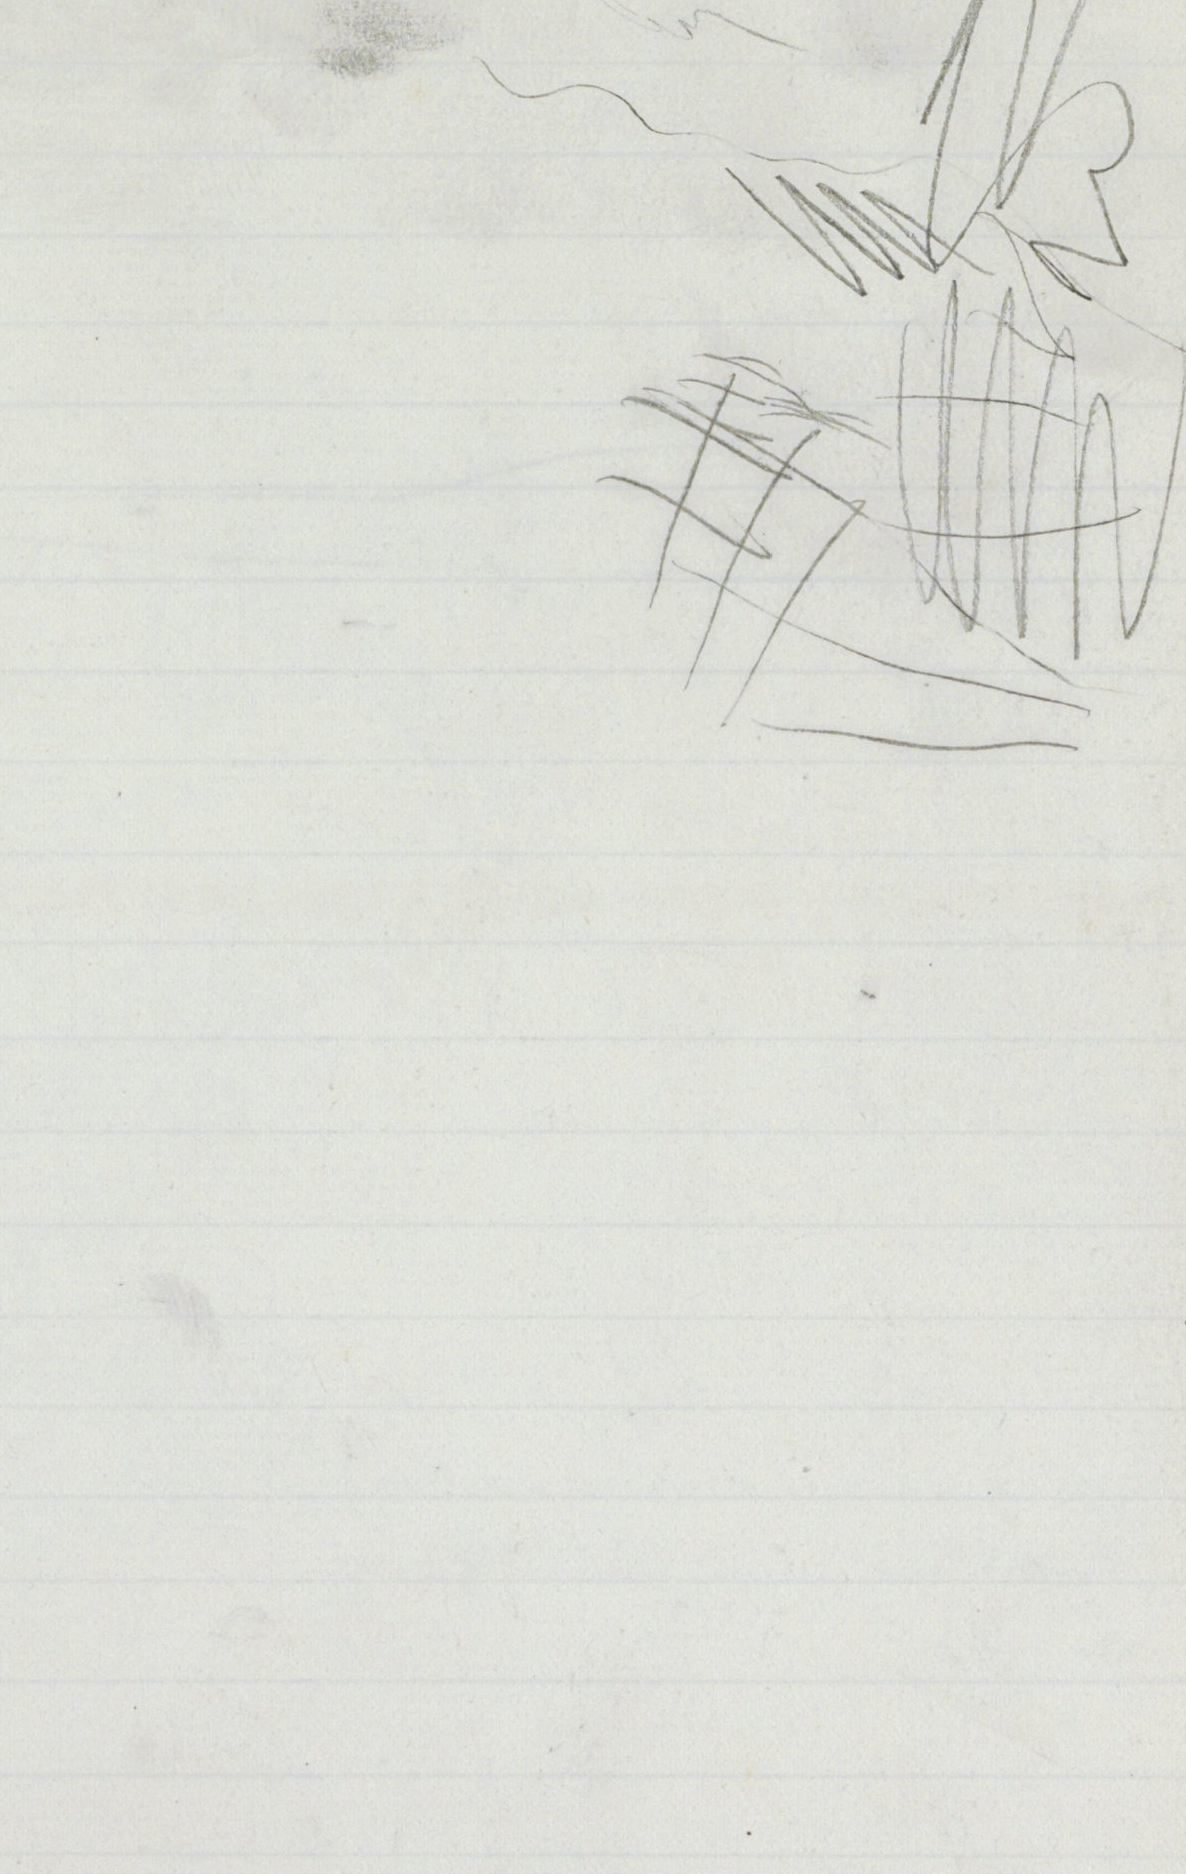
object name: sketchbook leaf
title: Studieblad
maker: marius bauer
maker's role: draughtsman, print maker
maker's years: 1867-1932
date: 1877-1932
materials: pencil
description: Pagina 78 uit een schetsboek met 68 bladen.